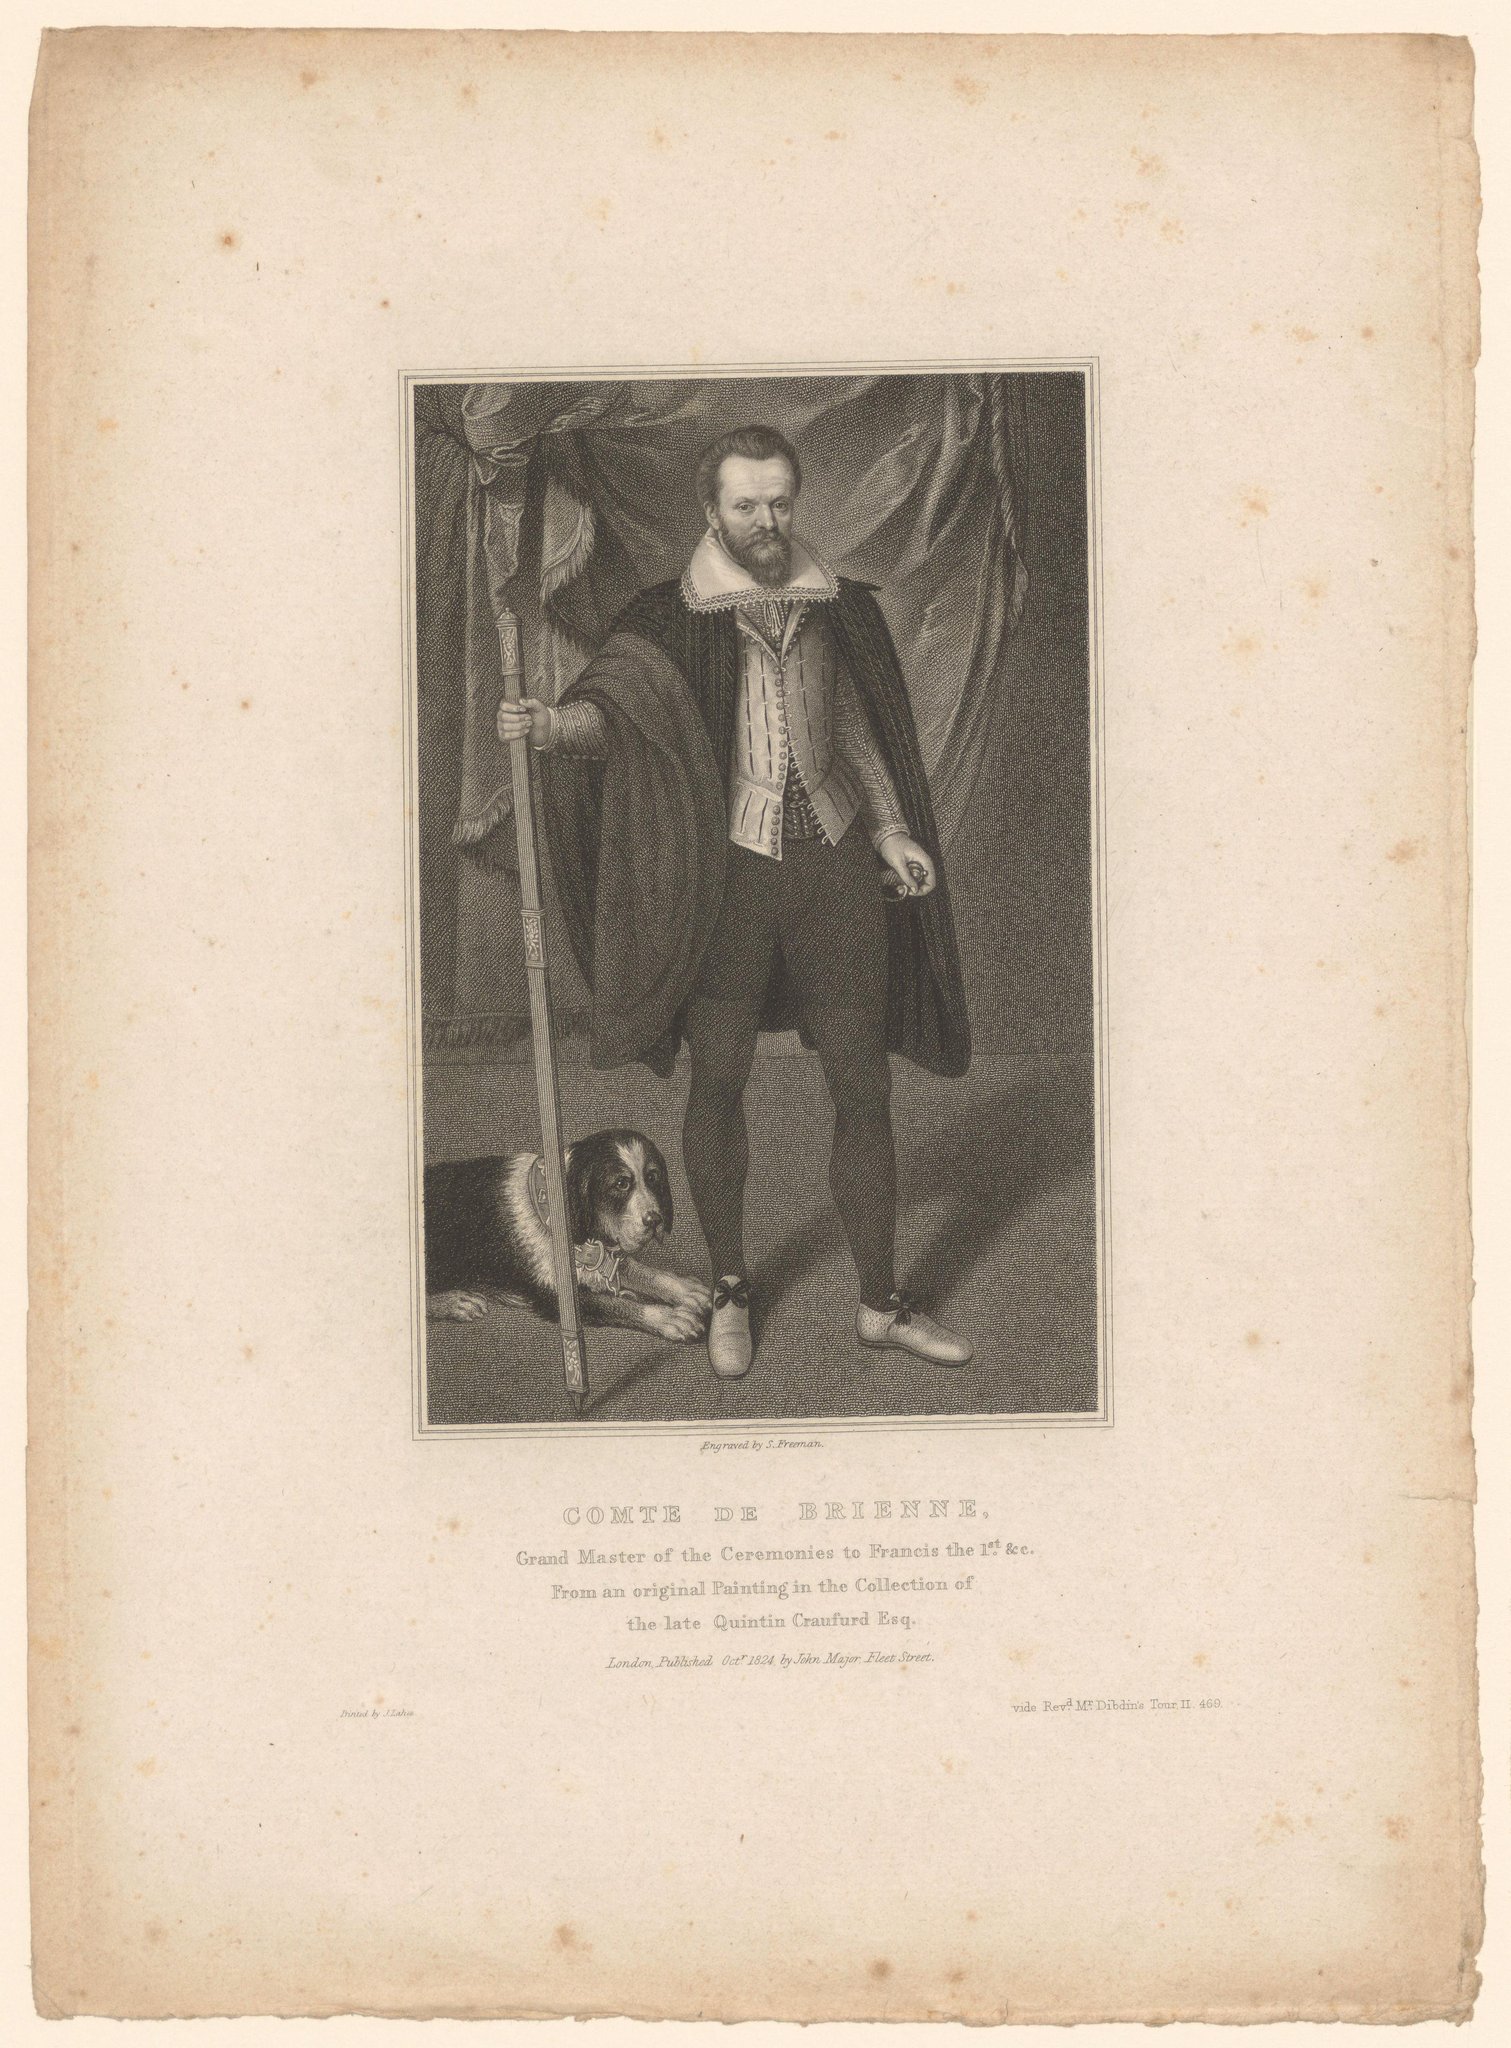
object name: print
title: Portret van Henri-Auguste Loménie de Brienne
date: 1810-1824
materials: paper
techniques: engraving, etching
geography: london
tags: politician, henri-auguste loménie de brienne, historical persons, politician, e.g. party leader, dog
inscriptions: collector's mark: Lugt 2228